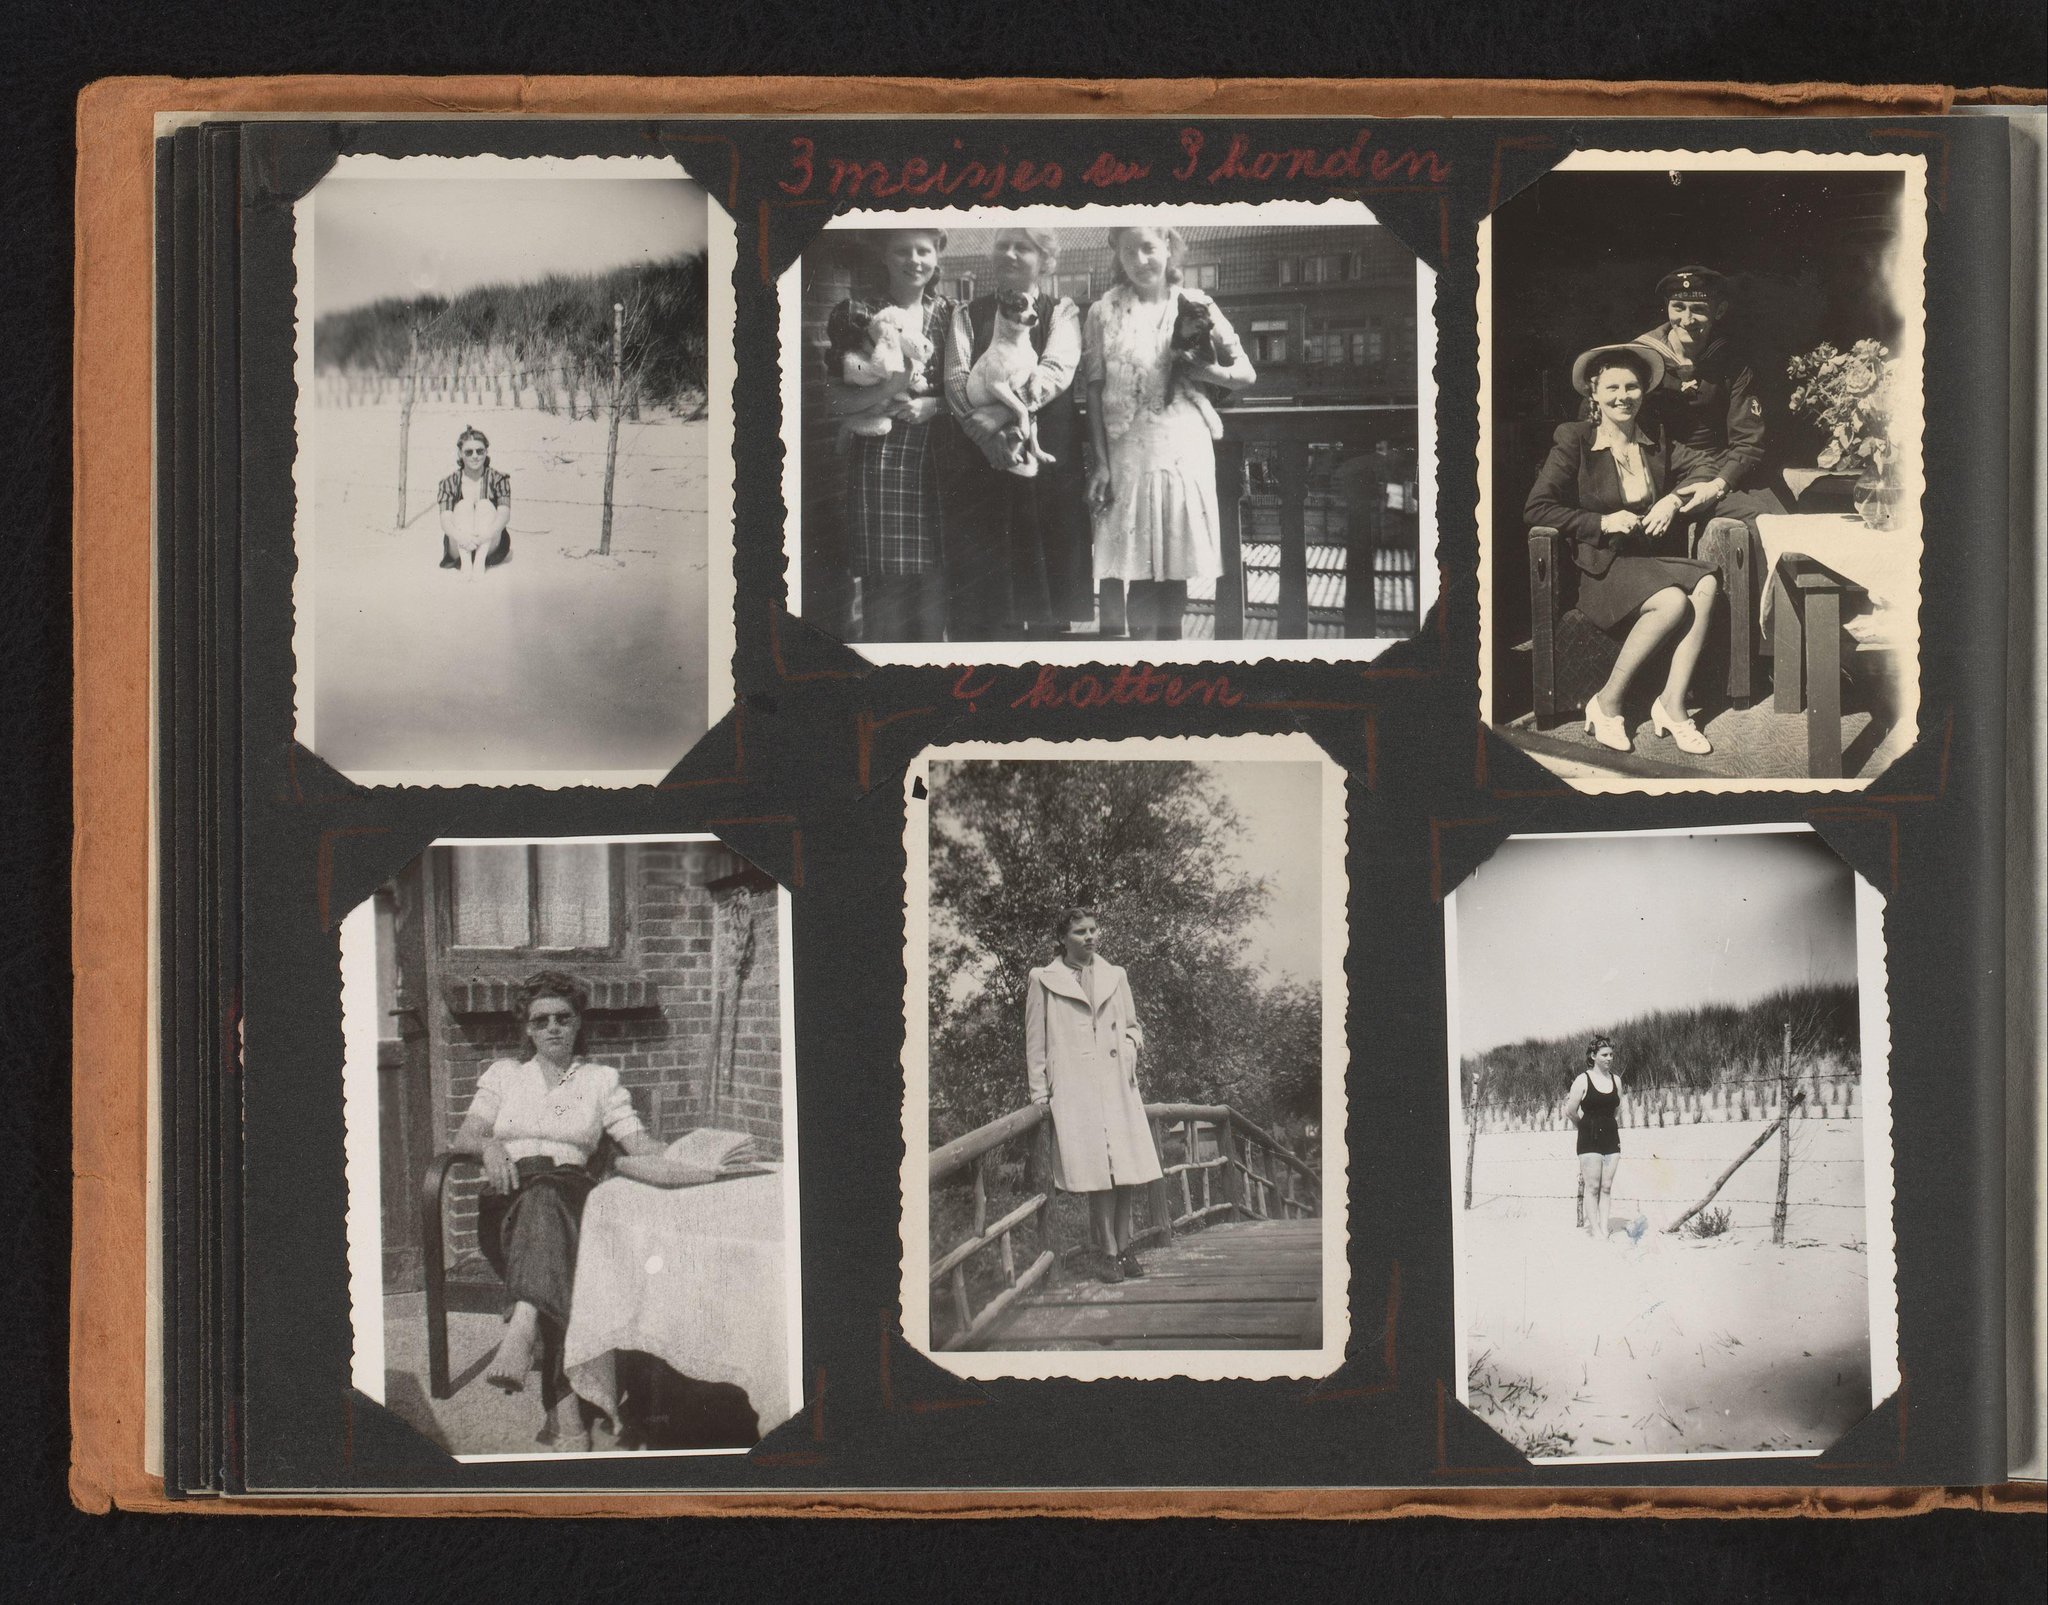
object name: photograph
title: Thea en vriendinnen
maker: Anonymous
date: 1938-1944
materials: paper, photographic support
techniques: gelatin silver print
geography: netherlands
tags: werner neufang, beach (as place of recreation), lovers; courting, flirting, netherlands, rotterdam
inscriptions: inscription, inscription: ‘3 meisjes met 3 honden / ? katten’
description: Albumblad met zes foto's van Thea Driesen, op het strand in Nieuw-Helvoet in 1938, in een park en thuis. Op een foto poseert ze in 1944 met samen met twee vriendinnen met hondjes in de armen, op een andere foto uit 1943 samen met Werner. Onderdeel van een fotoalbum over de Duitse Werner Neufang van de Kriegsmarine en de Nederlandse Thea Driesen.